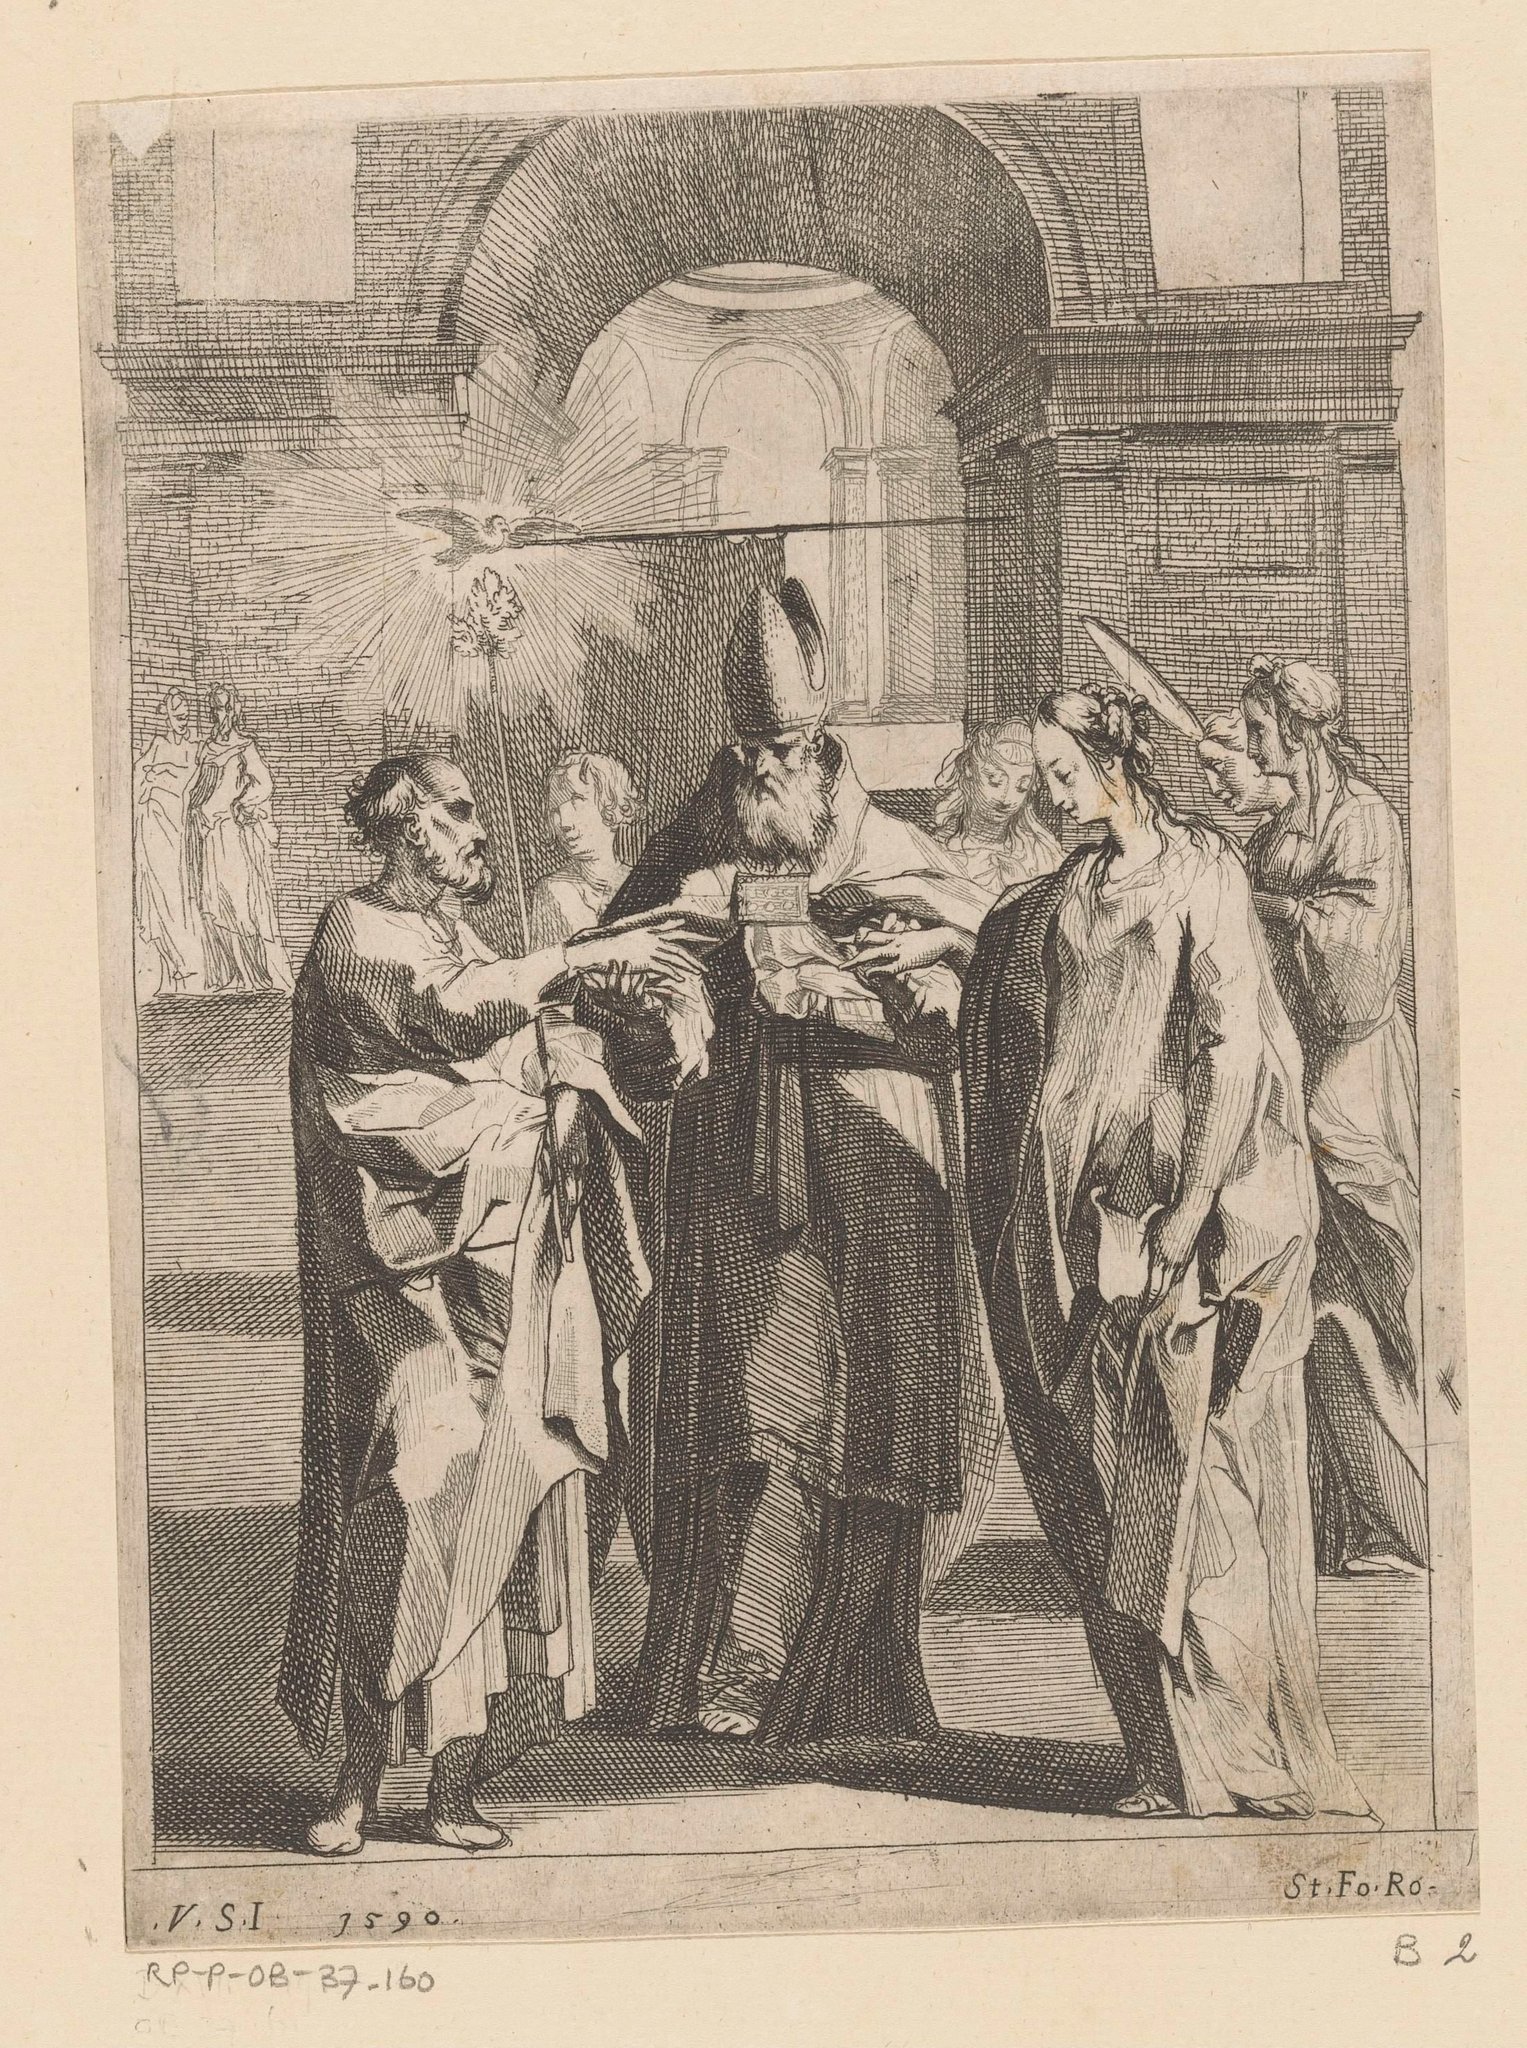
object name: print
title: Het huwelijk van Maria met Jozef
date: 1590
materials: paper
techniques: etching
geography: italy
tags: marriage of mary and joseph, 'sposalizio': they are married by the high priest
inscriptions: collector's mark: Lugt 240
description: Maria en Jozef worden door een hogepriester in de echt verbonden. Jozef houdt in zijn hand een tak met bladeren, waarboven de Heilige Geest in de gedaante van een duif zweeft.